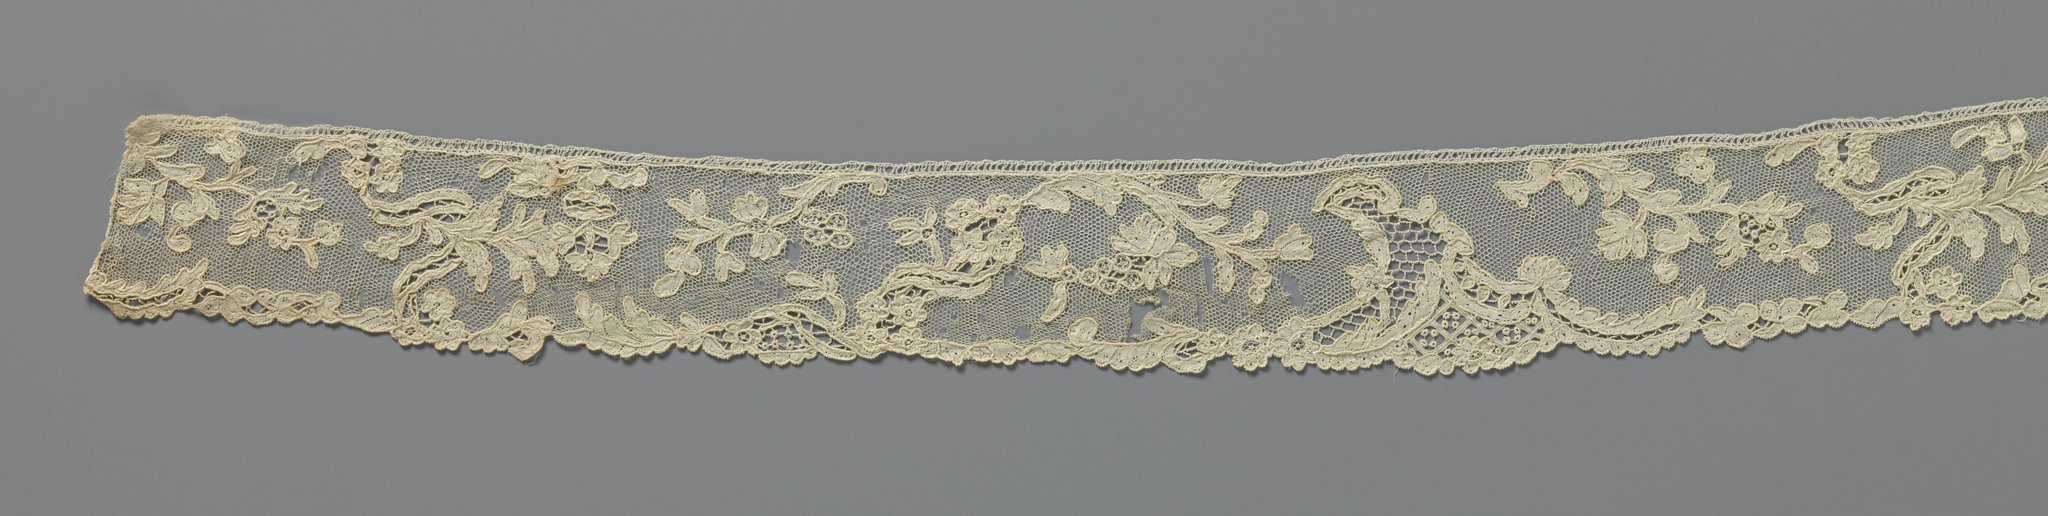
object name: strip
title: Strook naaldkant met rocaille-motief en bloemtakken met linten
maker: Anonymous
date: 1750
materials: linen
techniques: lace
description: Strook naturelkleurige naaldkant: Alençon-kant. Patroon met bloemtakken, af en toe omwikkeld met linten, op een fijne zeshoekige maasgrond. Tussen de takken een asymmetrisch rocaille-motief, opgevuld met verschillende siergronden. De bovenzijde is afgewerkt met een rand kloskant. De onderzijde is afgewerkt met een gepicoteerde schulpenrand, die voortkomt uit een patroon van liggende bladeren en bloemen en enkele met siergronden opgevulde ruimtes.